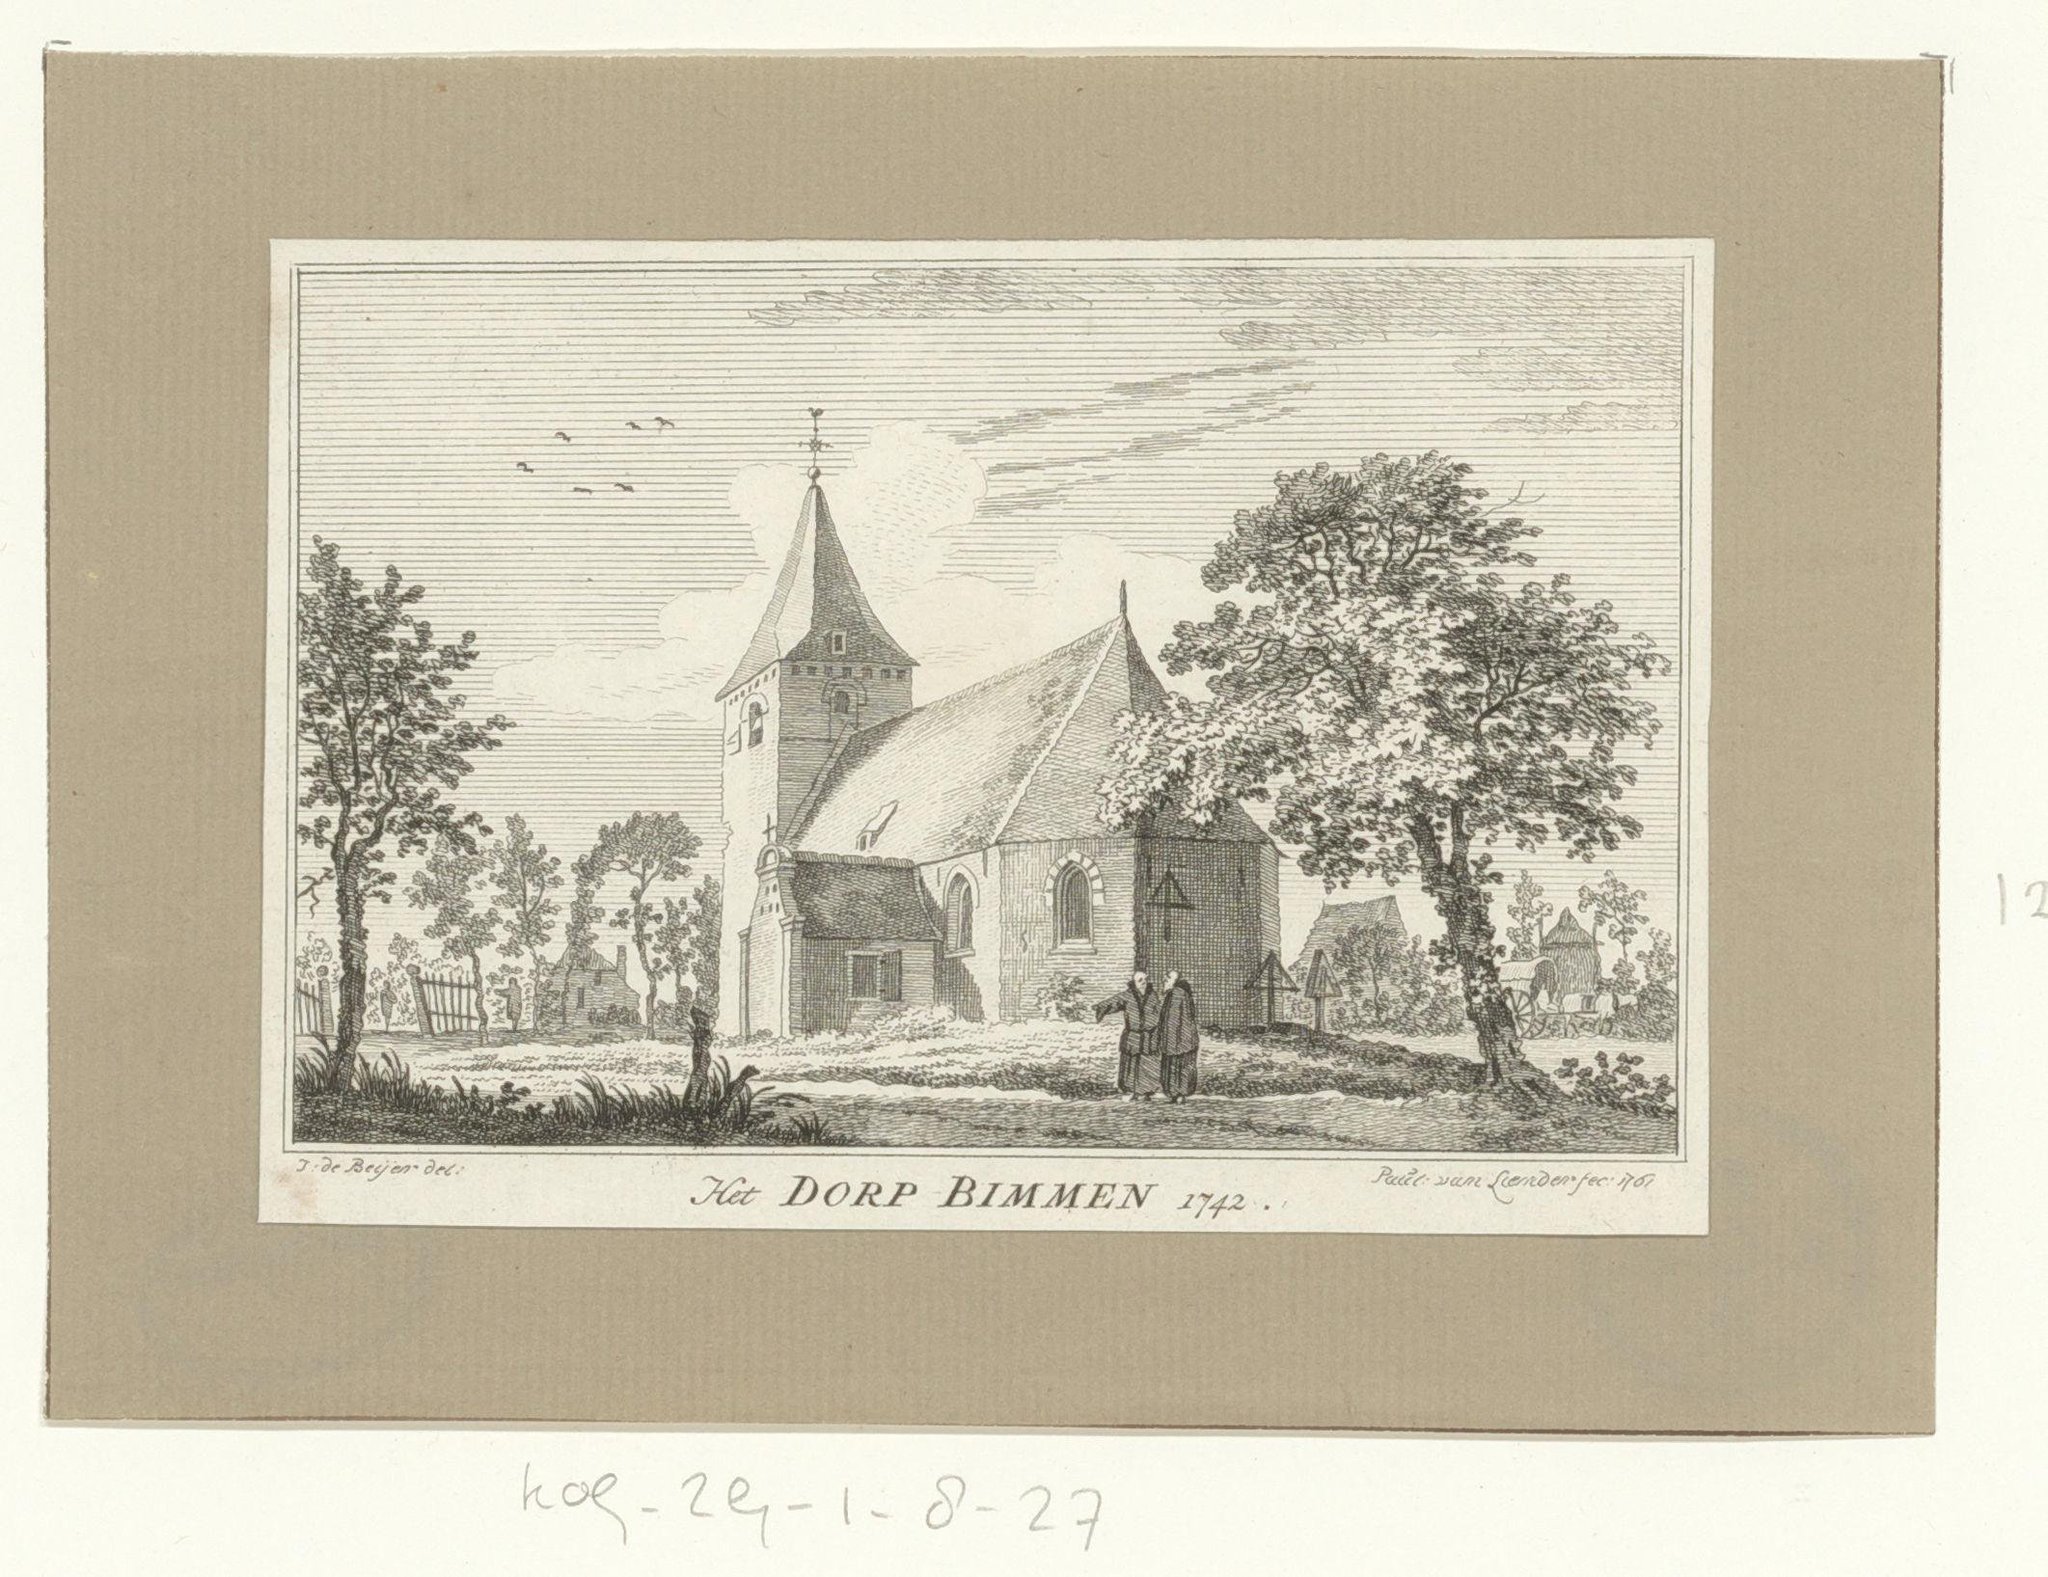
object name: print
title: Het Dorp Bimmen 1742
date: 1761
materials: paper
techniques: etching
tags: village, church (exterior)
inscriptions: collector's mark, collector's mark: Lugt 1641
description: Gezicht op de kerk in het dorp Bimmen in Duitsland, omstreeks 1742. Onderste helft van een plaat met twee voorstellingen. De prent maakt deel uit van een 100-delige serie met gezichten op dorpen en steden te Kleef. Onderwerpsrubrieken binnen de Atlas Zeden en Gewoonten: Kerk en kerkwezen & Armwezen en liefdadige instellingen; Kerkgebouwen elders. A-E.